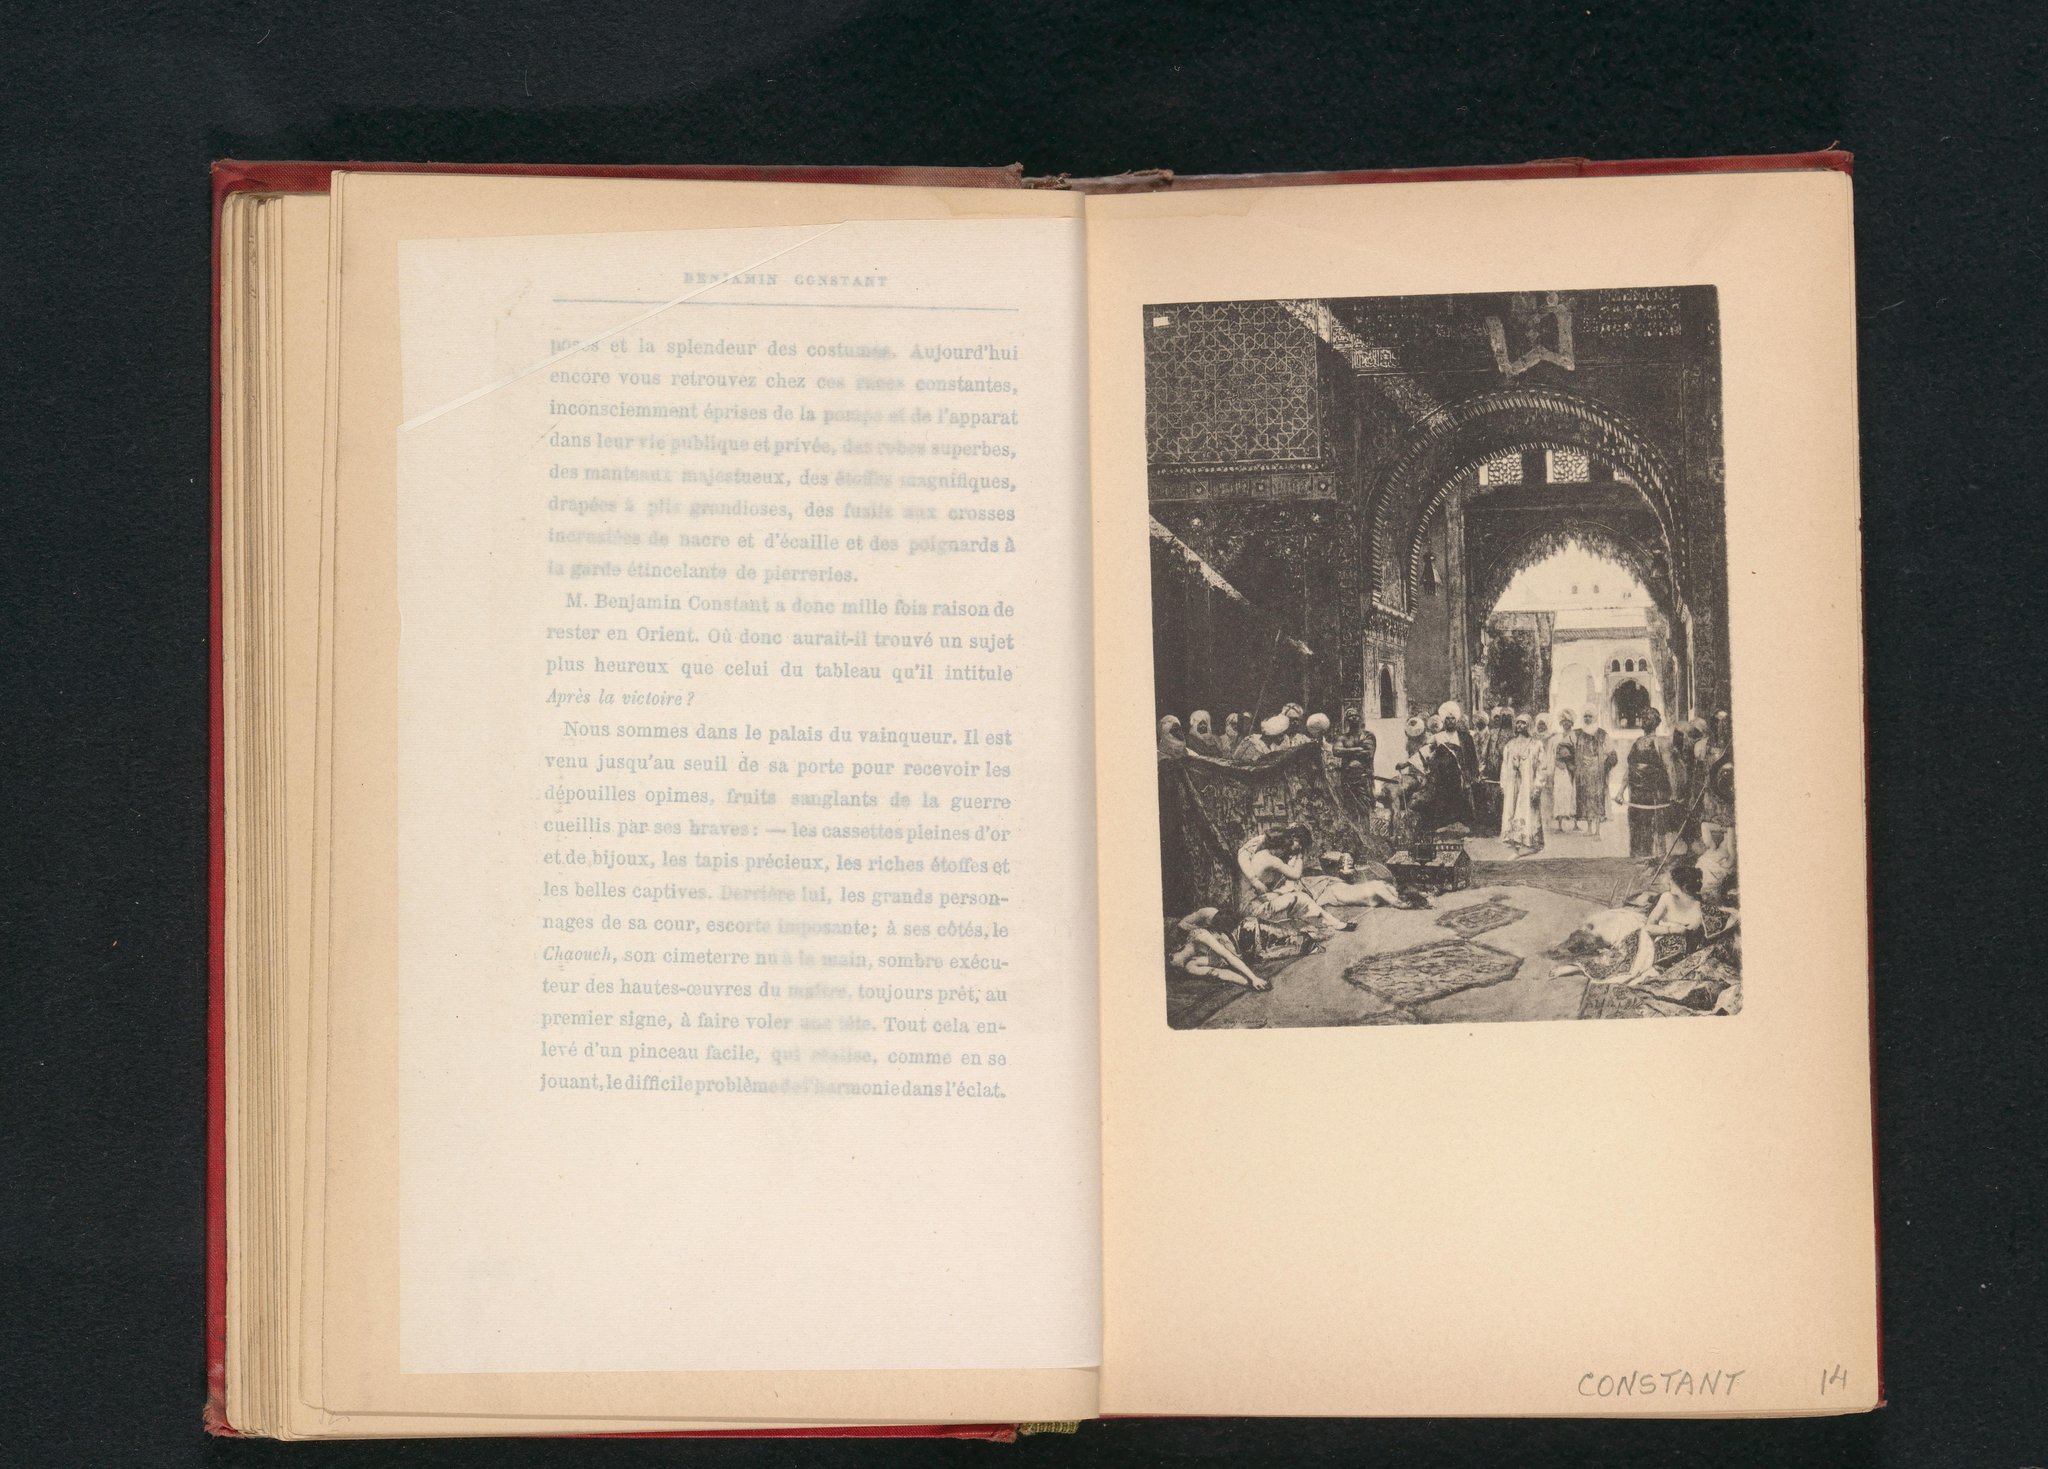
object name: reproduction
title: Fotoreproductie van het schilderij Après la victoire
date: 1872-1882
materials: paper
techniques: photograph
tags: march into the conquered place